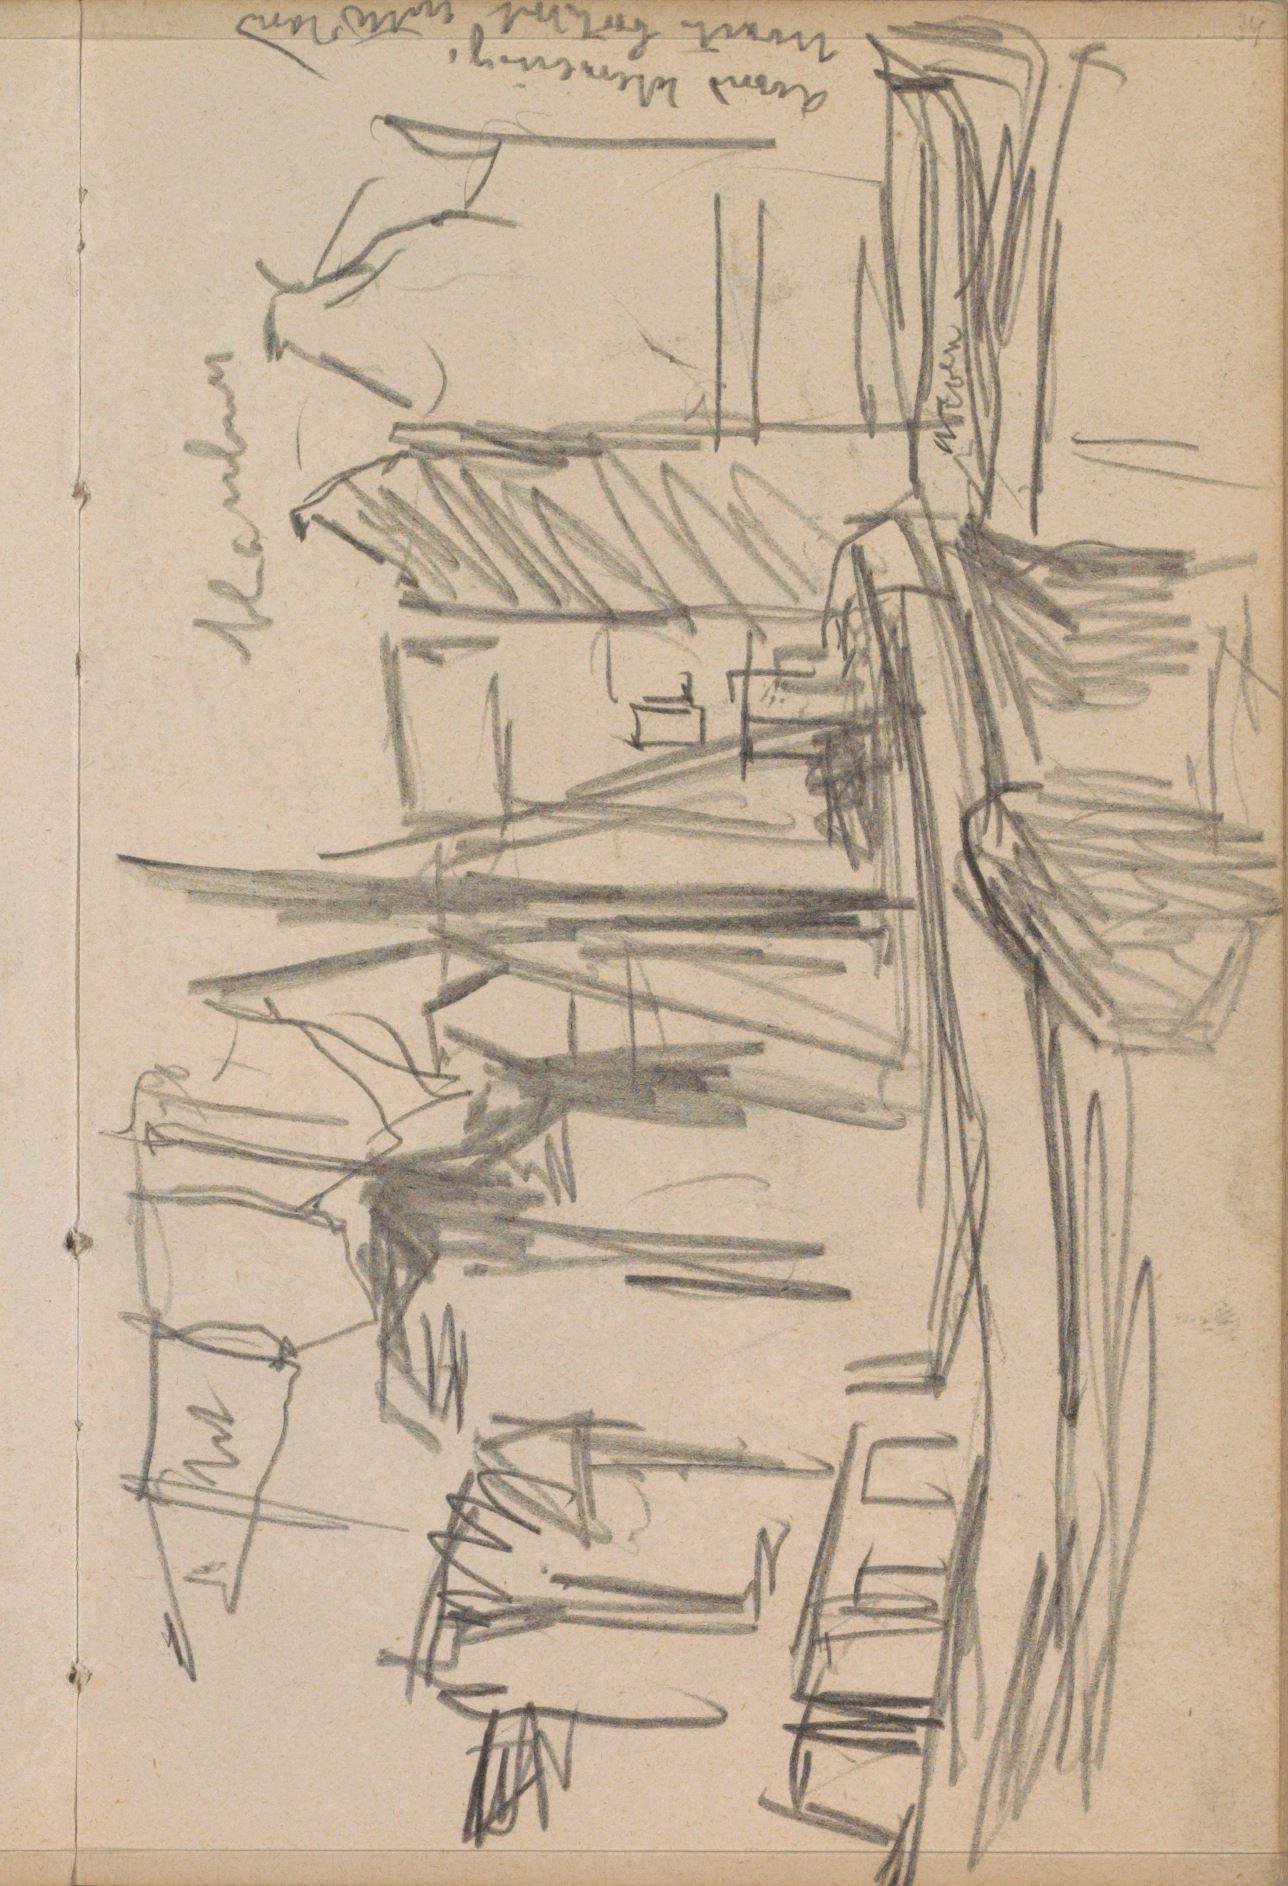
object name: sketchbook leaf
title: Gezicht op het Damrak te Amsterdam met boten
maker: george hendrik breitner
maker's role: draughtsman, painter, print maker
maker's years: 1857-1923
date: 1902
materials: paper, pencil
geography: amsterdam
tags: urban housing, ships (in general), canals, waters (in city)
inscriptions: annotation: ‘Avond schemering./ zwarte boot met witte rand’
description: Pagina 34 uit een schetsboek met 46 bladen vervaardigd in de omgeving van Amsterdam, Rotterdam en Haarlem.